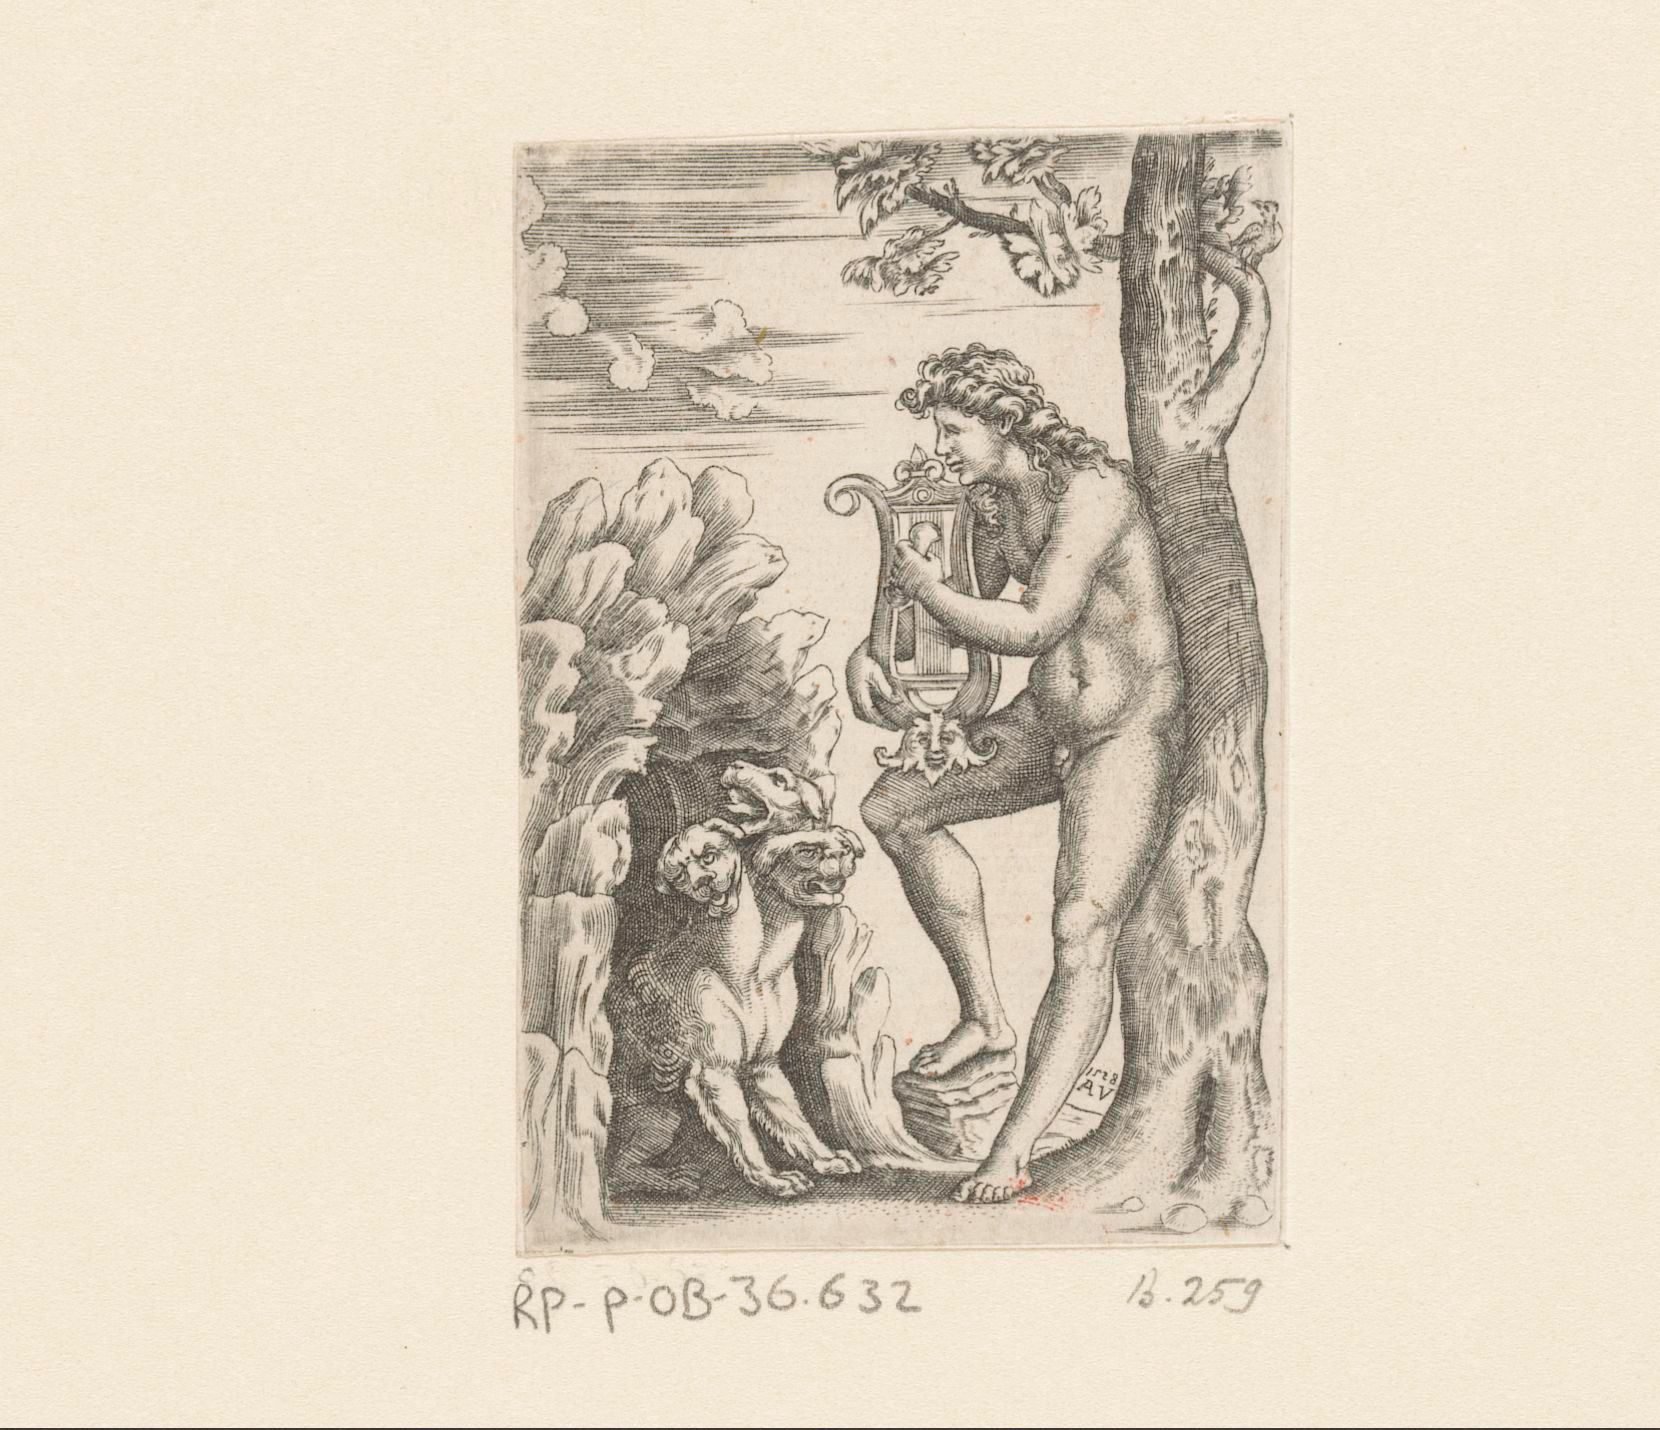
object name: print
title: Orpheus betovert Cerberus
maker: agostino veneziano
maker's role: draughtsman, painter, print maker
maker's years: 1490-1536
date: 1528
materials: paper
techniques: engraving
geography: italy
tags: entrances to hades, orpheus and eurydice, orpheus playing the lyre, cerberus, the three- or many-headed dog; 'cerbero' (ripa)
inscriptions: collector's mark: Lugt 12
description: Orpheus staat rechts tegen een boom met zijn lier in de hand. Links bewaakt de driekoppige hond Cerberus de poort van de onderwereld. Orpheus betovert Cerberus met zijn lierspel om toegang tot de onderwereld te verkrijgen.